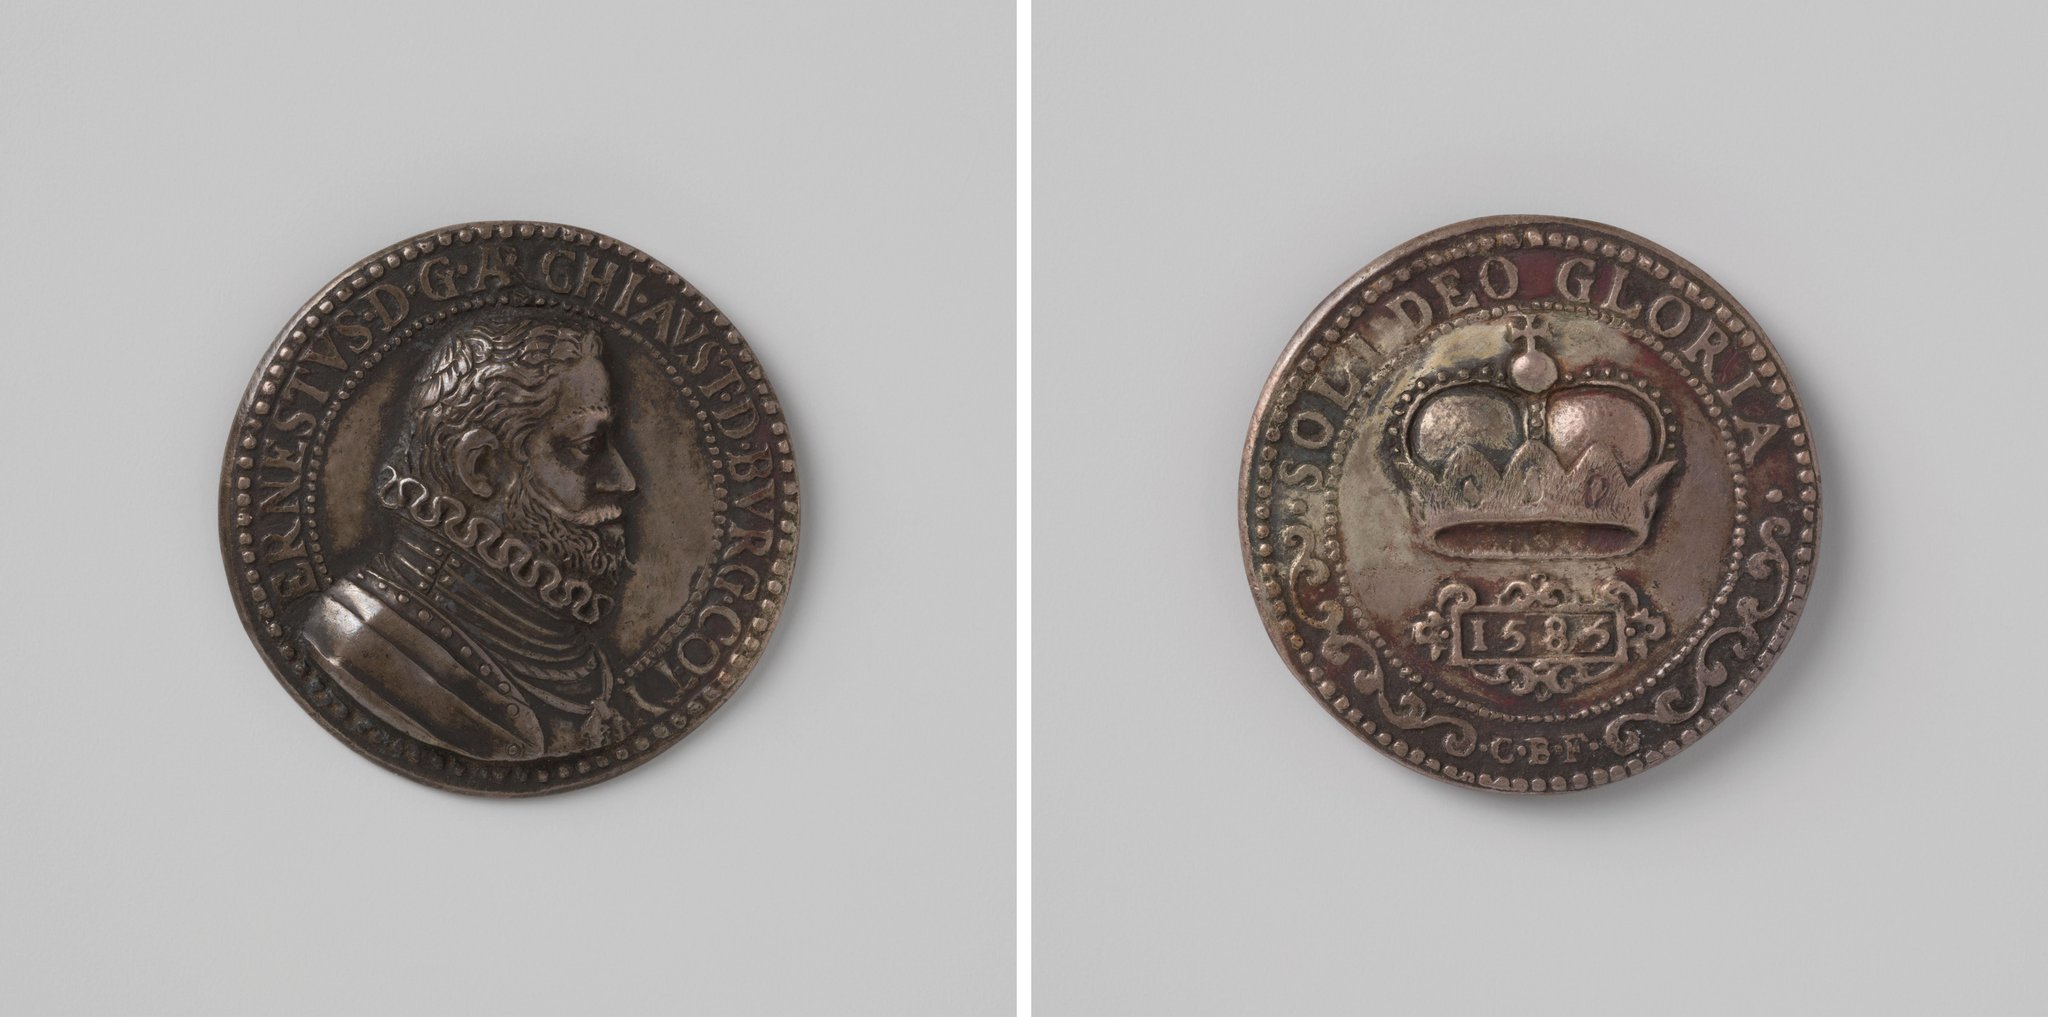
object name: history medal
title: Ernst, aartshertog van Oostenrijk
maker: coenraad bloc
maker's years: 1545-1602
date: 1585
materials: silver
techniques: casting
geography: flanders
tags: vienna, brussels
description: Zilveren penning. Voorzijde: borststuk man binnen omschrift. Keerzijde: kroon boven cartouche met jaartal binnen omschrift